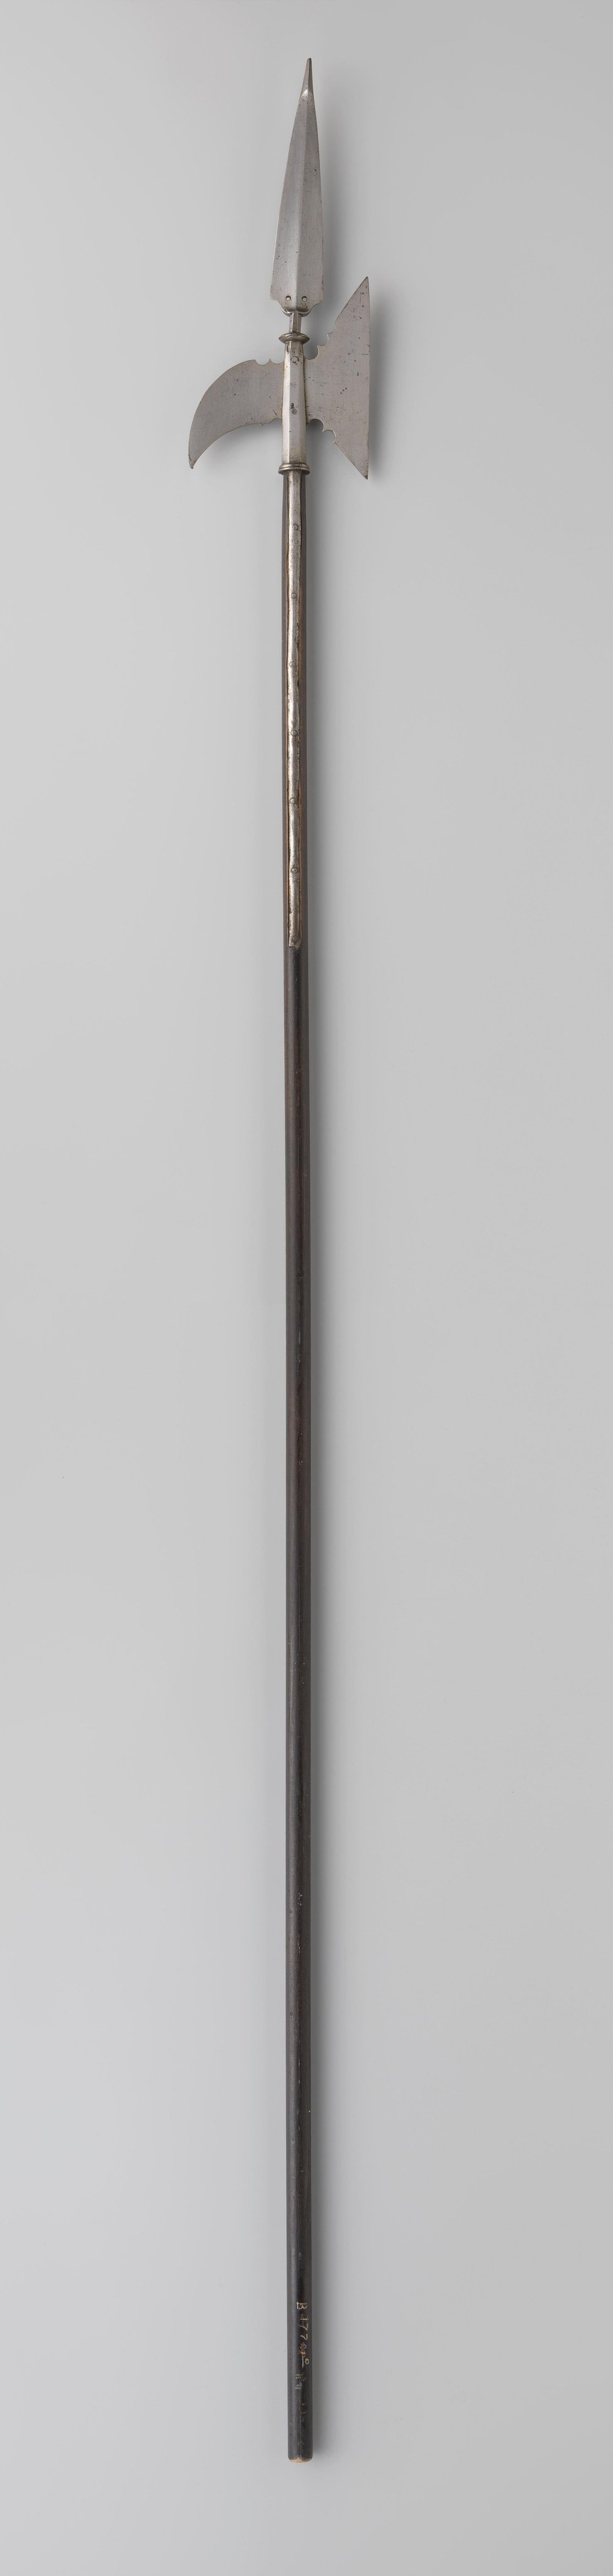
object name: halberd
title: Sergeantshellebaard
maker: Anonymous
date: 1650-1700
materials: iron, wood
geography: low countries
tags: low countries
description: Korte kling met een sterke taps toelopende vorm met een scherpe middengraat; onderin twee doorboringen. Zeshoekig taps toelopend huis met bovenaan een schijfvormige knop en een ringvormig profiel onder. Het huis heeft een dwars doorgaande spleet waar de bijl en haak, die tot één geheel gesmeed zijn, doorheen zijn gestoken. Dit geheel is vastgezet met twee plat gevijlde klinknagels. Zowel de bijl als de haak hebben kommavormige uitsnijdingen. Aangeklonken veren. Ronde (essenhouten) stok (zwartgeverfd) zonder schoen.